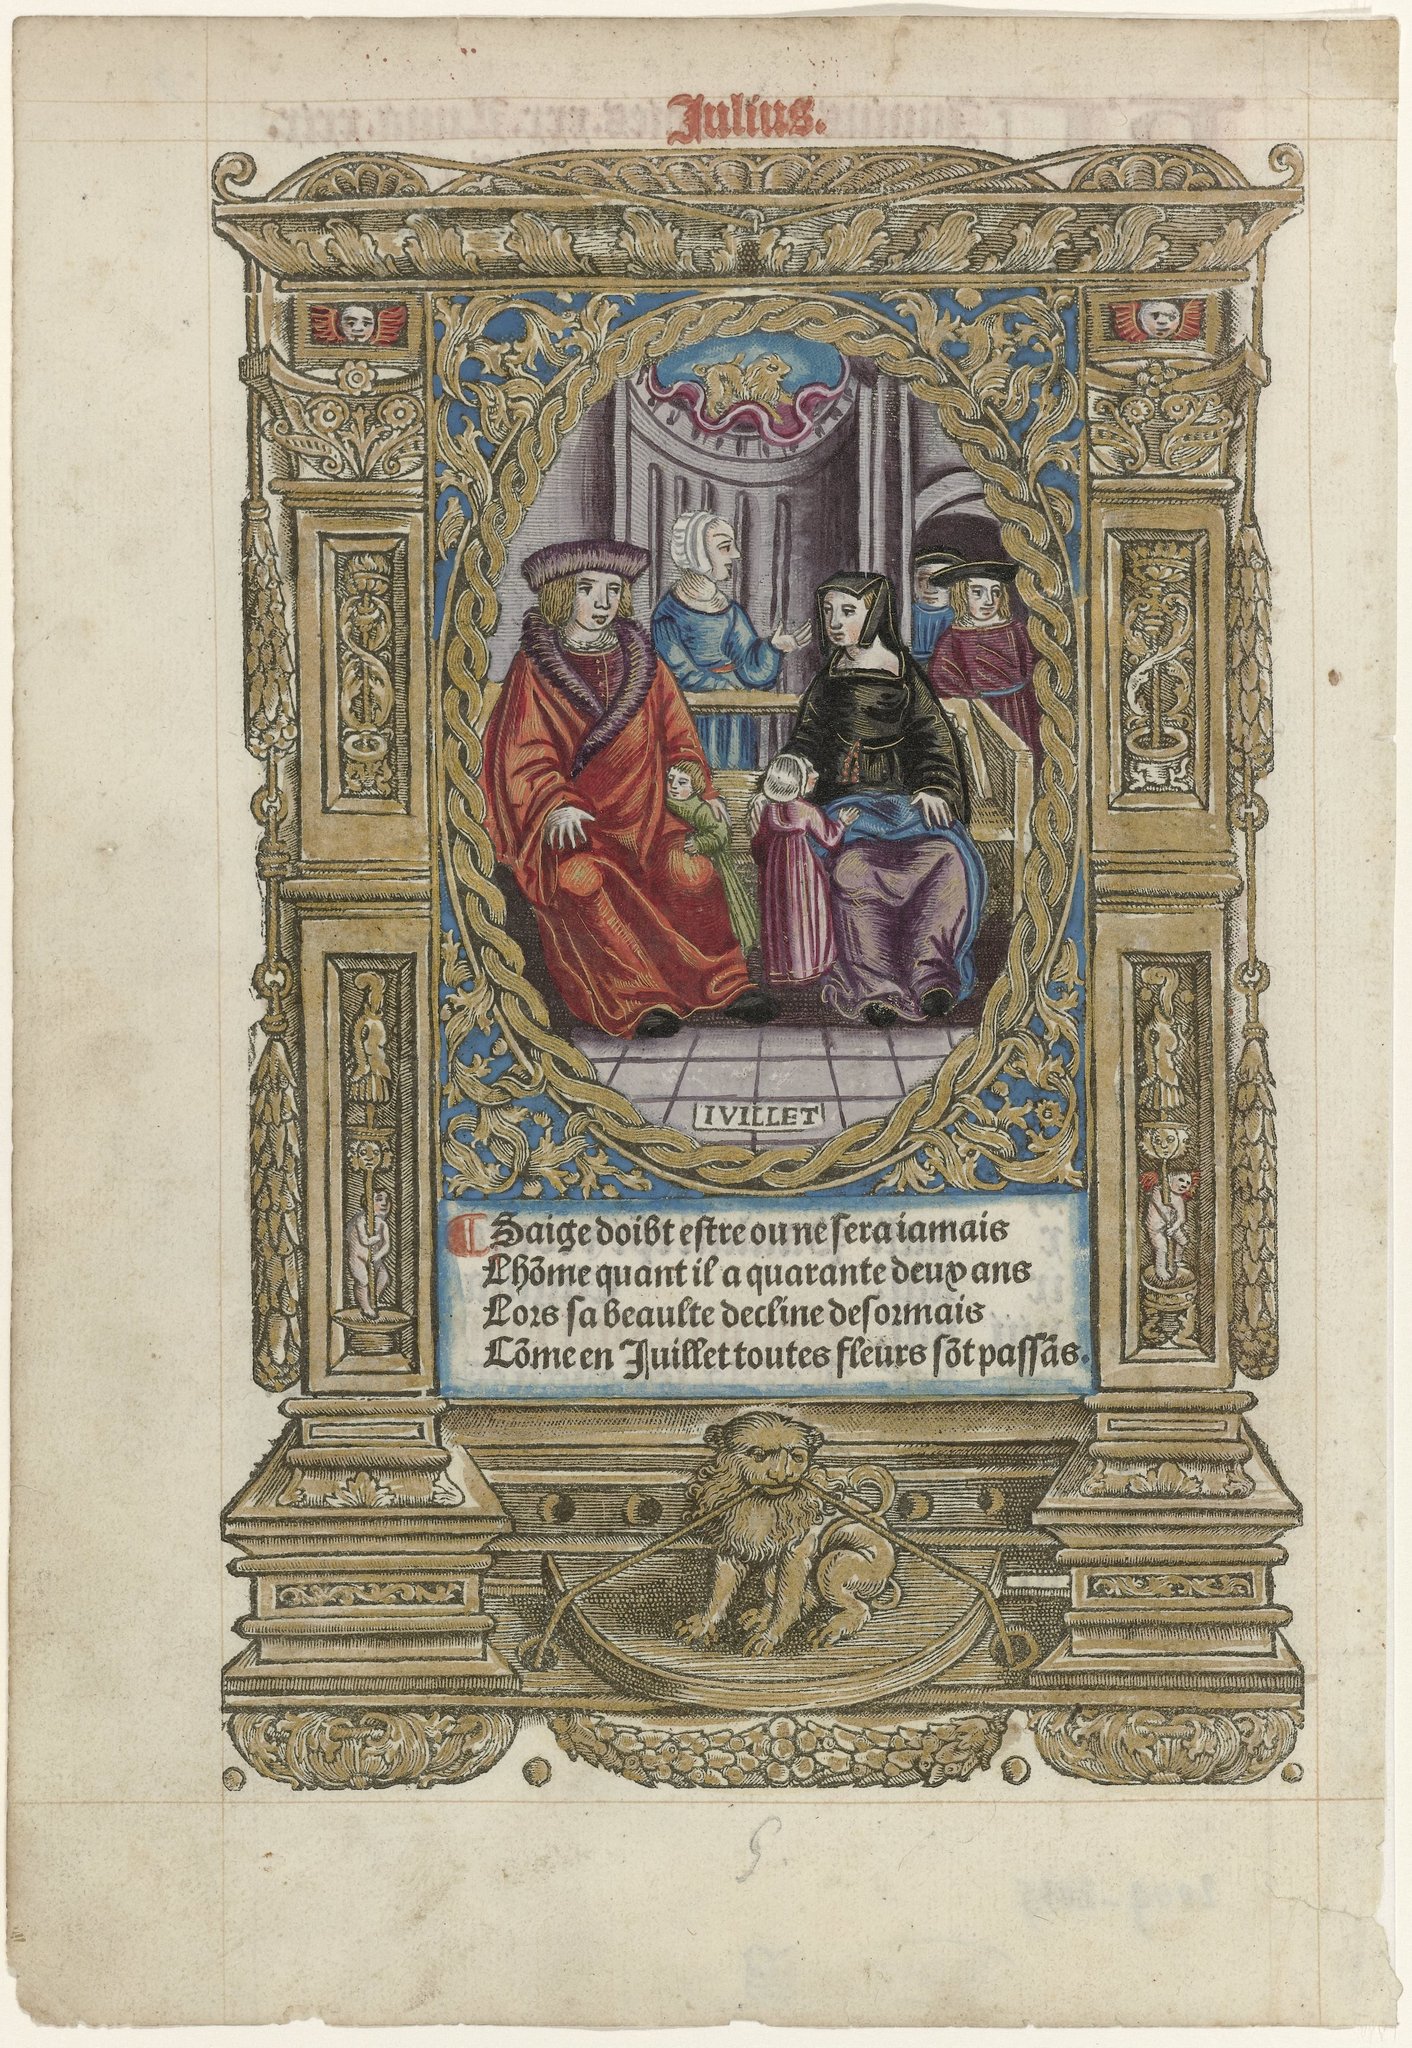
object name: book illustration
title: Julius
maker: Anonymous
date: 1520-1525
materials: paper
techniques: hand coloring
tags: coat (+ men's clothes), dress, gown (+ women's clothes)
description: De maand juli: Boekblad: elegant geklede dame en heer, zittend in een vertrek op een bank. Bij hen twee kinderen. Drie figuren achter hen. In ovale lijst, welke is gevat in ornamentale architectonische omlijsting met middenonder een leeuw. In cartouche 4-regelig Frans onderschrift over de veertig-jarige leeftijd van de mens en de maand juli. Verso: kalender